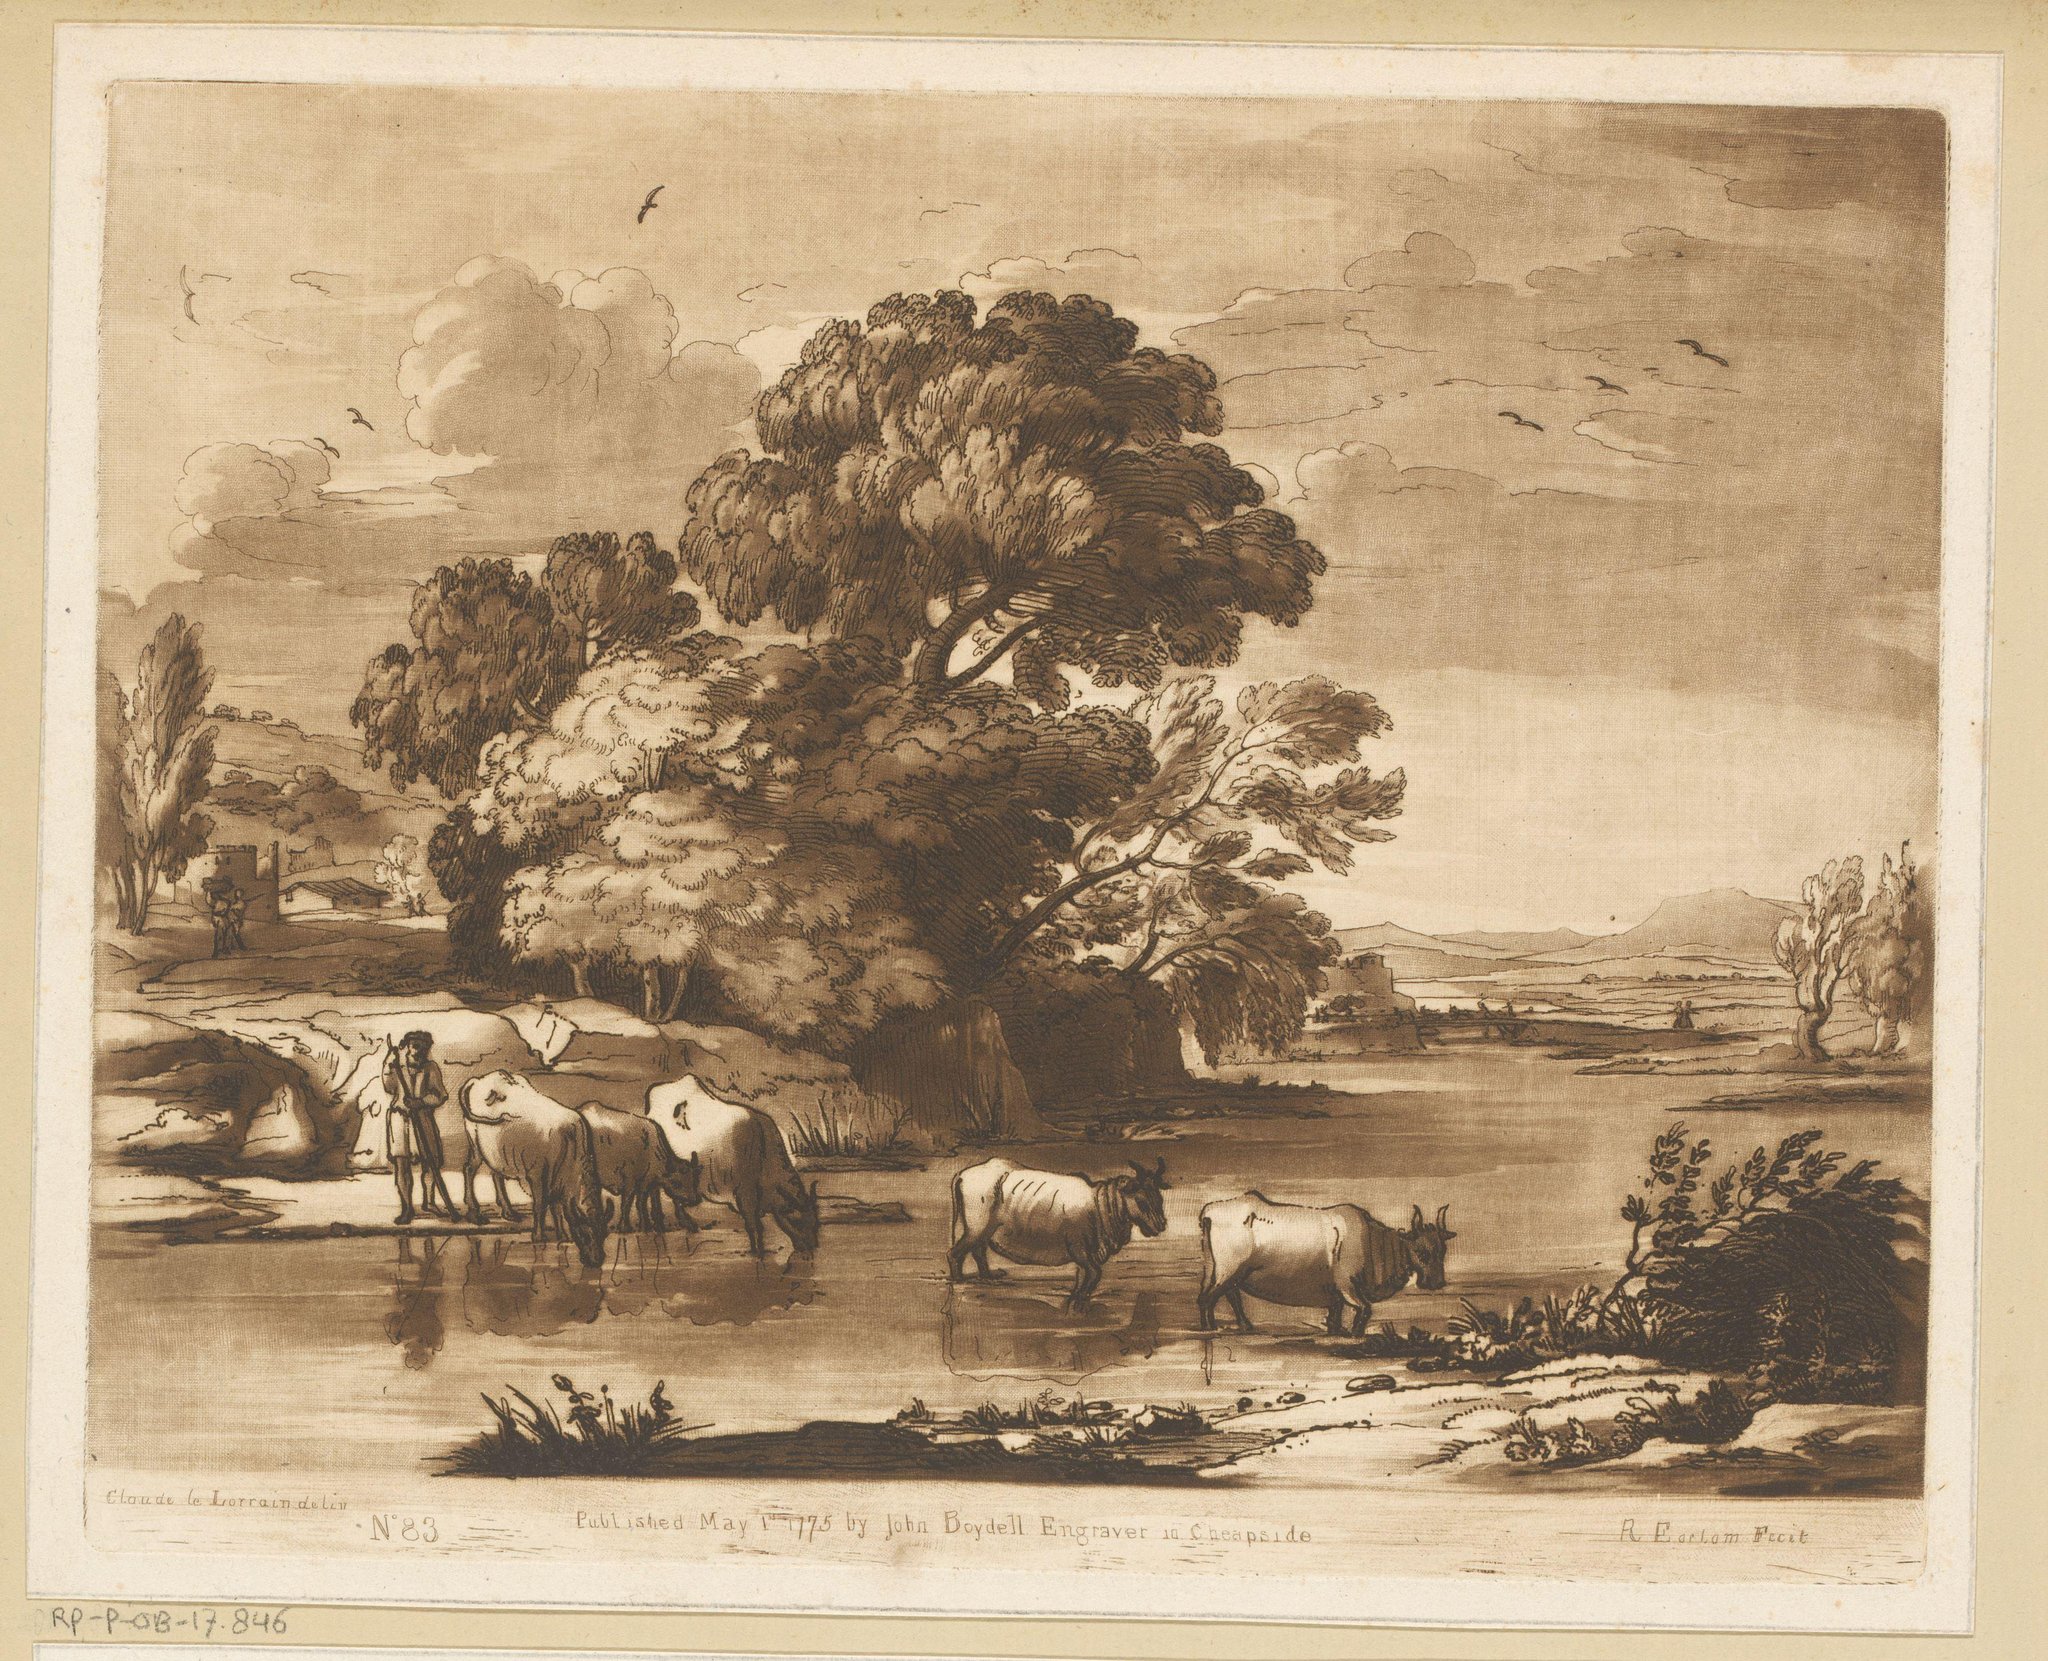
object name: print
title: Landschap met vijf koeien en een herder die een rivier oversteken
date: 1775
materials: paper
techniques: etching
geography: london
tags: river - hh - ideal landscapes, crossing a river, cattle driving, cattle driver, pastorals, arcadian scenes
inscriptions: date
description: Vanaf 1774 publiceerde John Boydell tweehonderd prenten naar het tekeningenboek Liber Veritatis van Claude Lorrain, in het bezit van de hertogen van Cavendish. Deze prenten werden vanaf 1777 in twee volumes gebundeld uitgegeven.